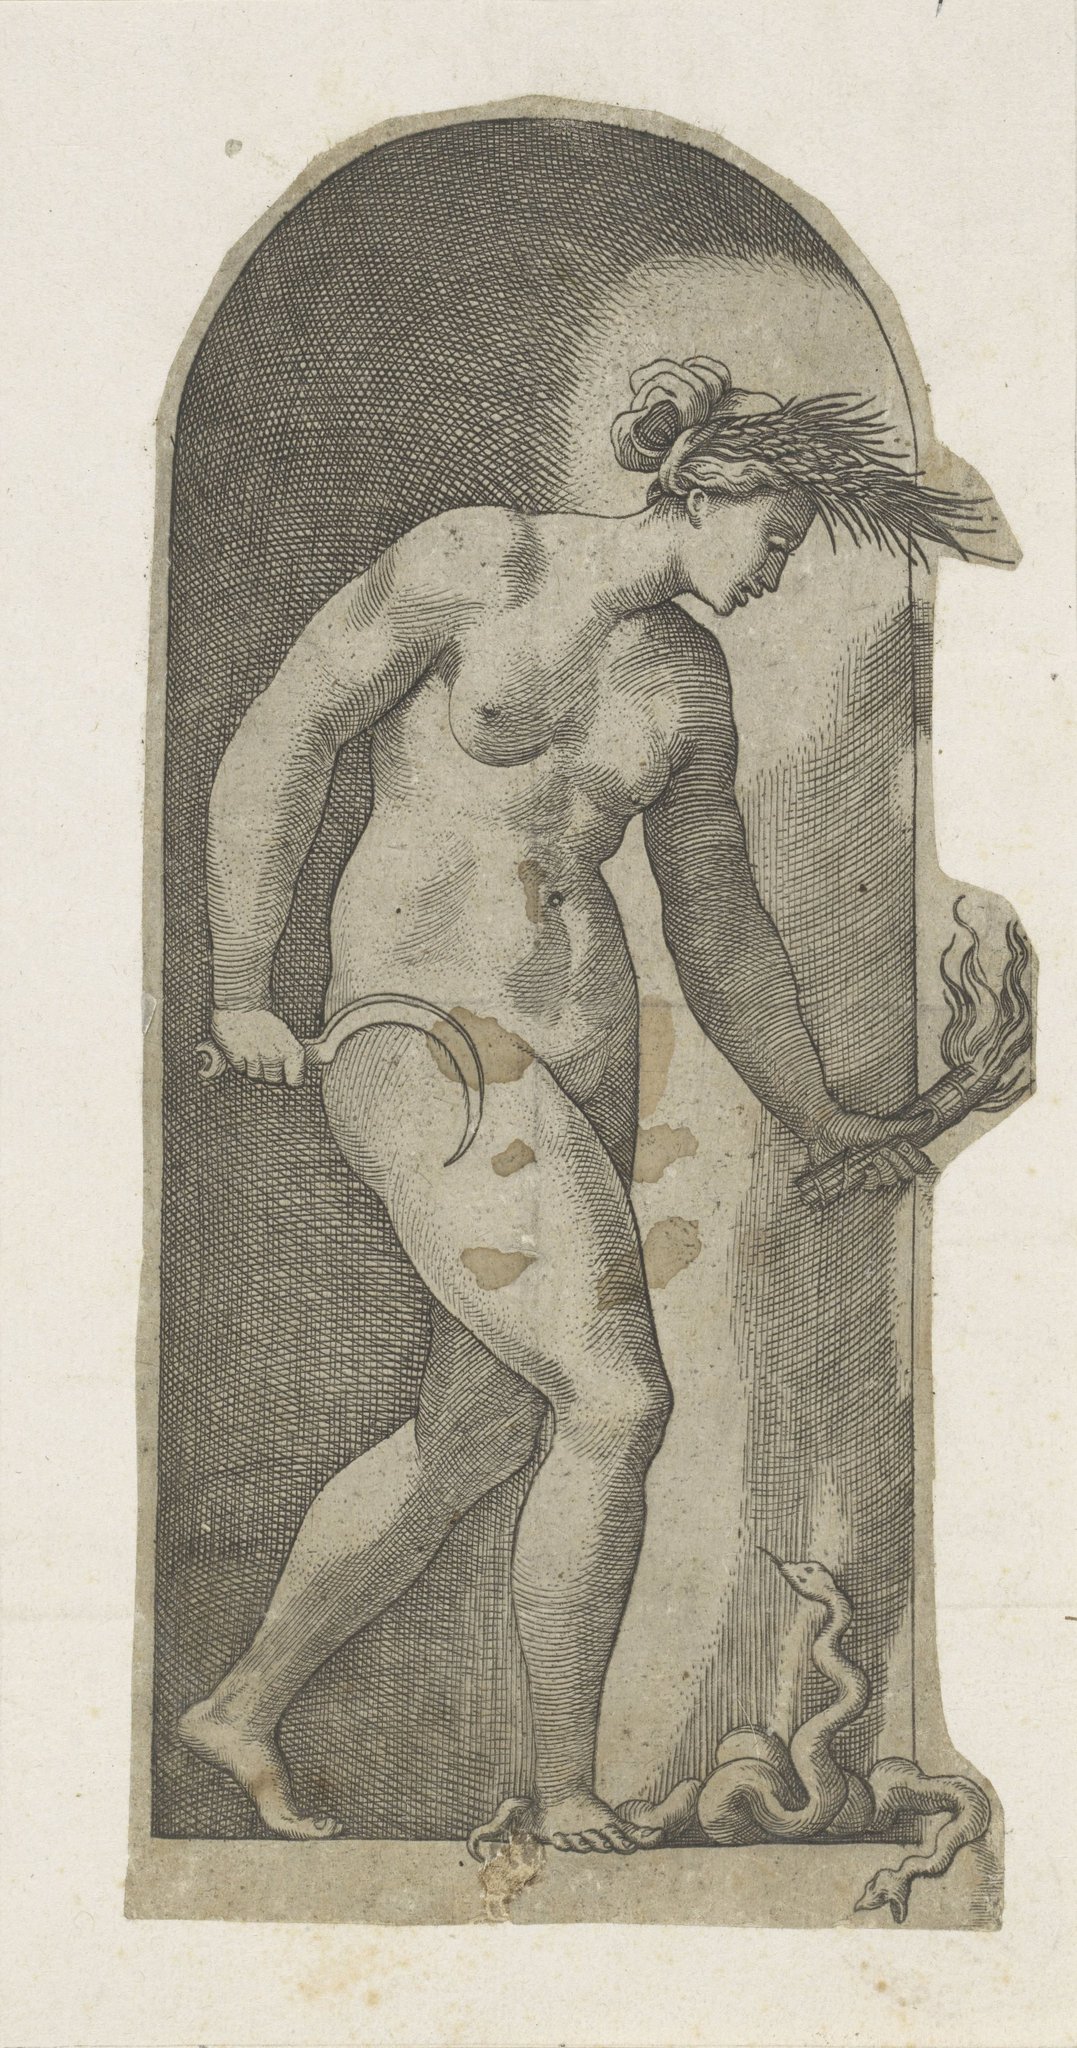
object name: print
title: Goden in nissen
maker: jacob binck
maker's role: painter, print maker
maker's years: 1494-1569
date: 1510-1569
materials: paper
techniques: engraving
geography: italy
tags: (story of) ceres (demeter)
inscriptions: collector's mark: Lugt 240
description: Prent uit een reeks van 20 prenten. Tekst in ondermarge uitgesneden. Voorstelling rond de contour uitgeknipt.